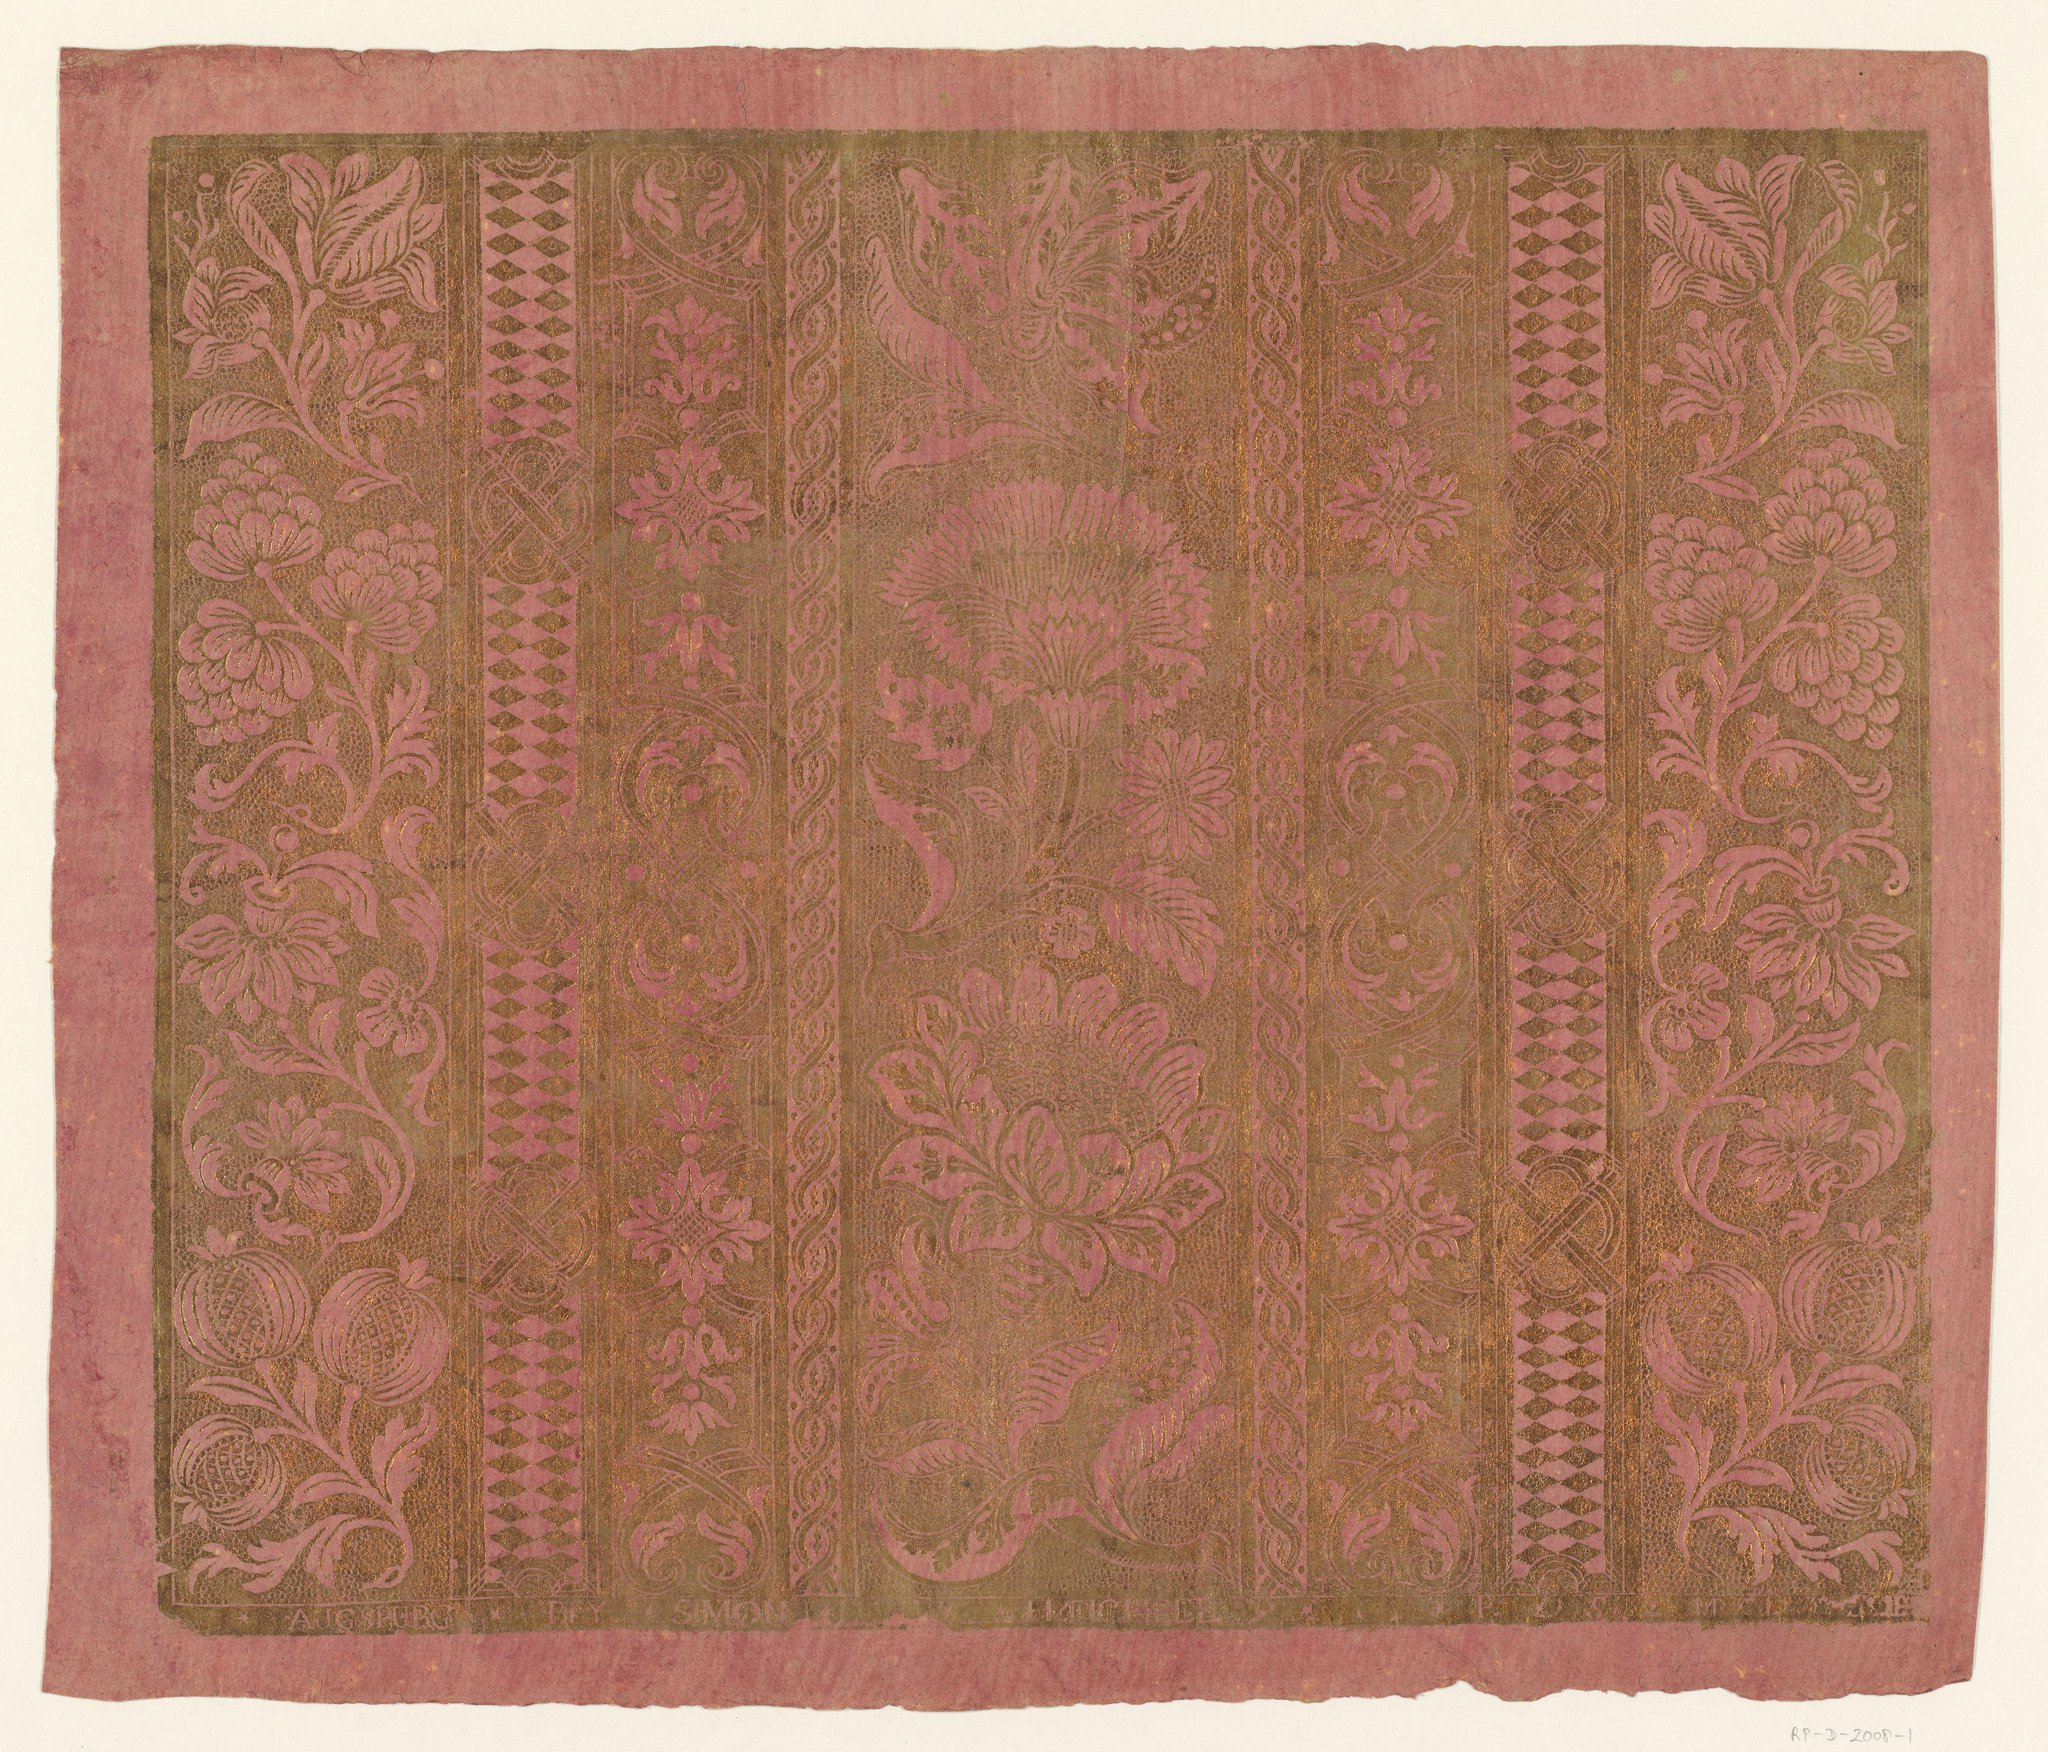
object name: brocade paper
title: Blad met drie banden met bloemen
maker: simon haichele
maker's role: papierfabrikant, papiermaker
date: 1740-1750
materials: gold leaf, paint, paper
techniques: relief print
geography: augsburg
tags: ornament ~ geometric motifs, ornament derived from plant forms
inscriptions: collector's mark: Lugt 2228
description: Blad met drie banden met bloemen gescheiden door smallere banden met ornamentele patroon en ruitenpatroon. De buitenste vier banden links en rechts spiegelbeeldig identiek. Genummerd onderaan: [onleesbaar].